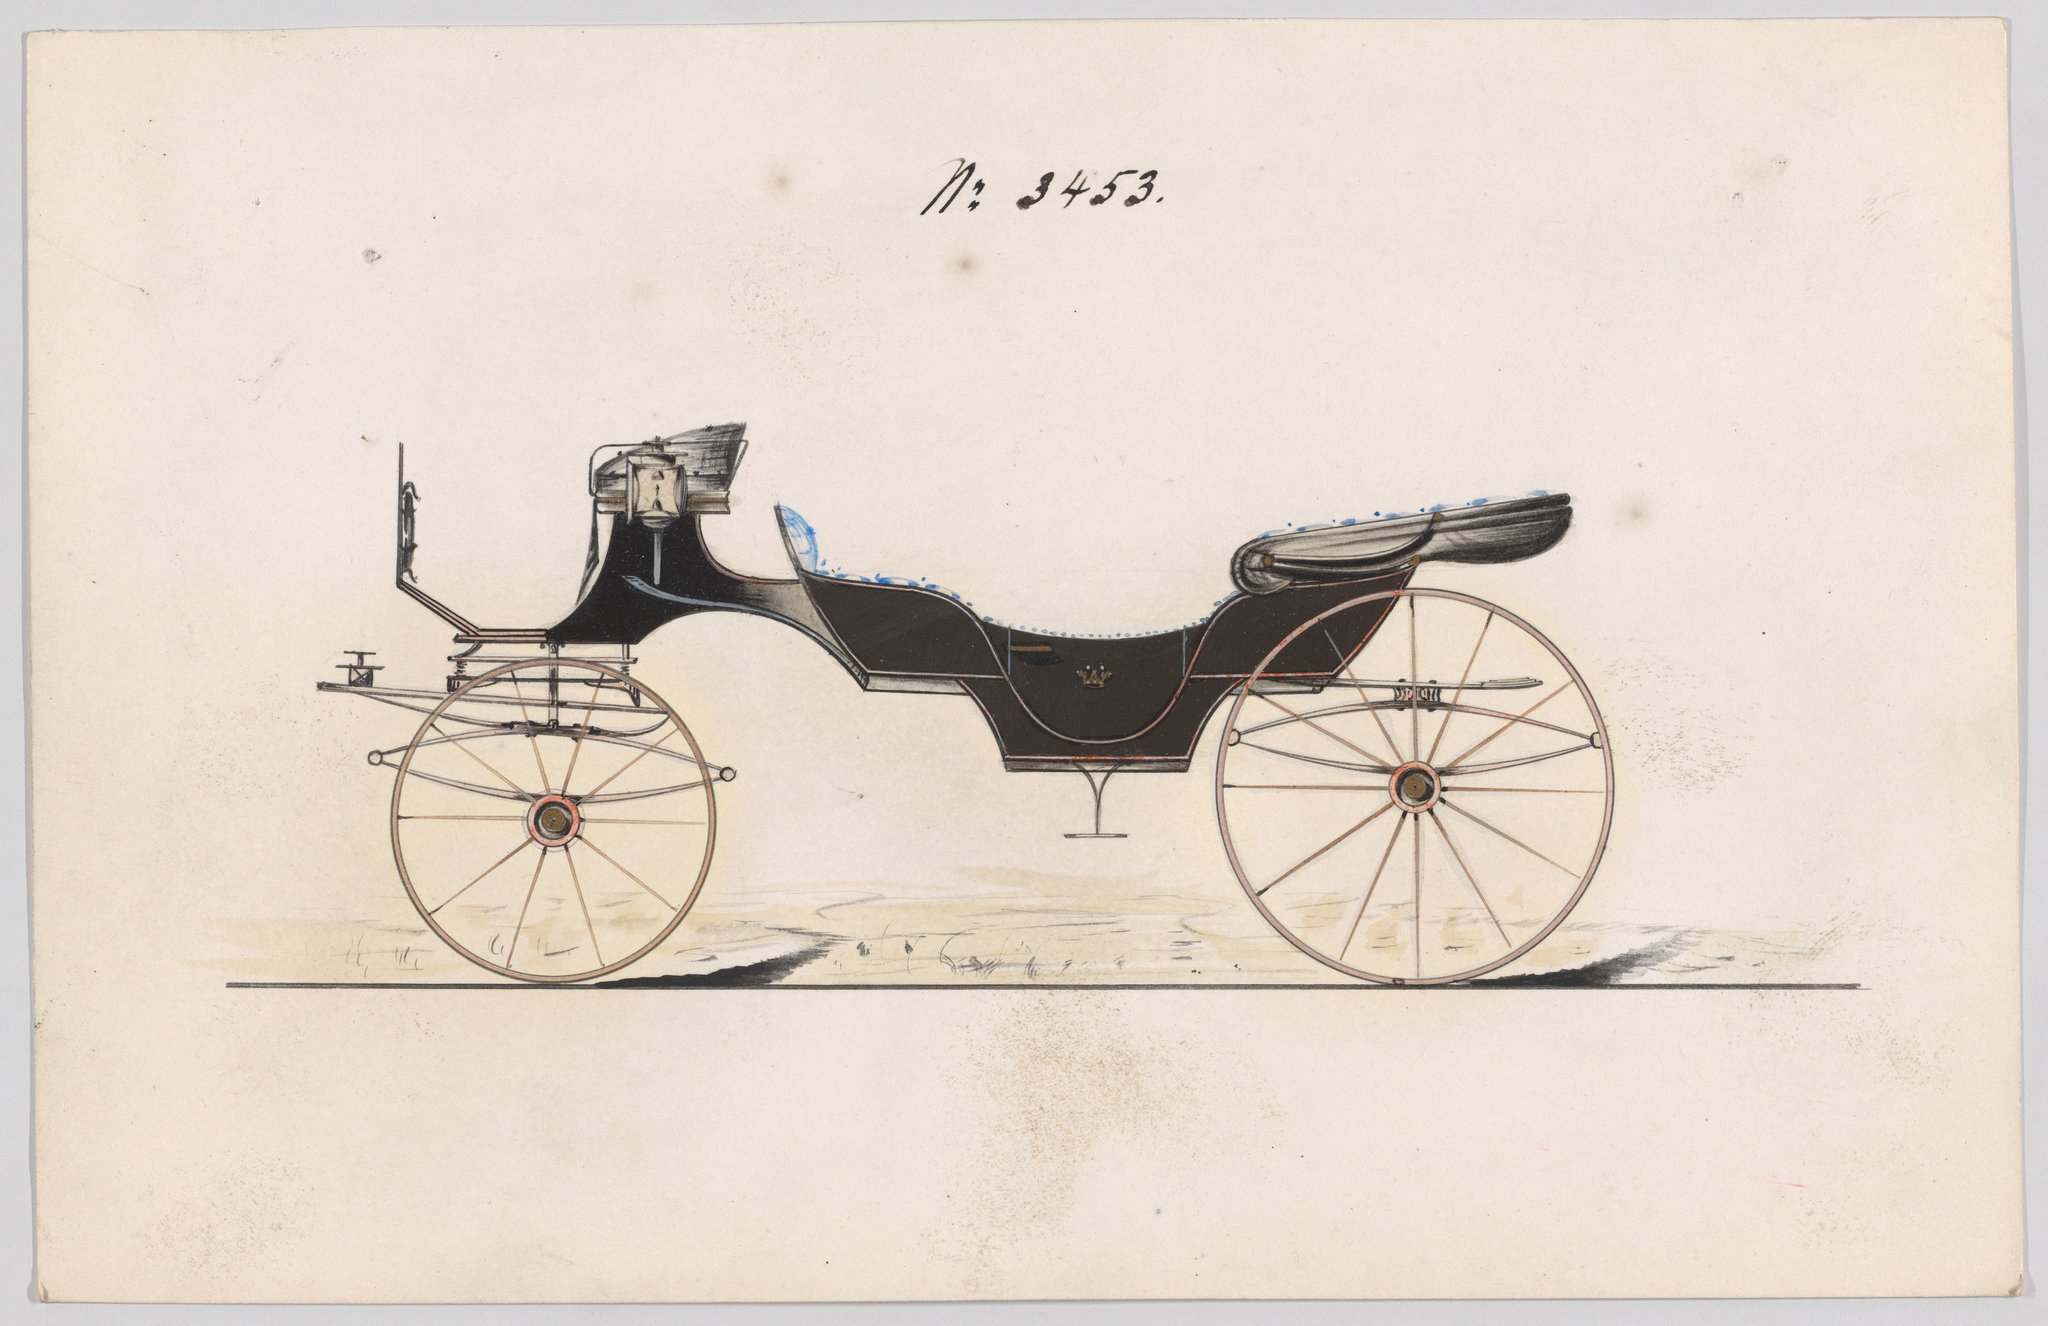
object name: drawing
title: Vis-à-vis #3453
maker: brewster & co.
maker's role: manufacturer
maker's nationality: american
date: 1878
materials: gouache, ink, watercolor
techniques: pen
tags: carriages